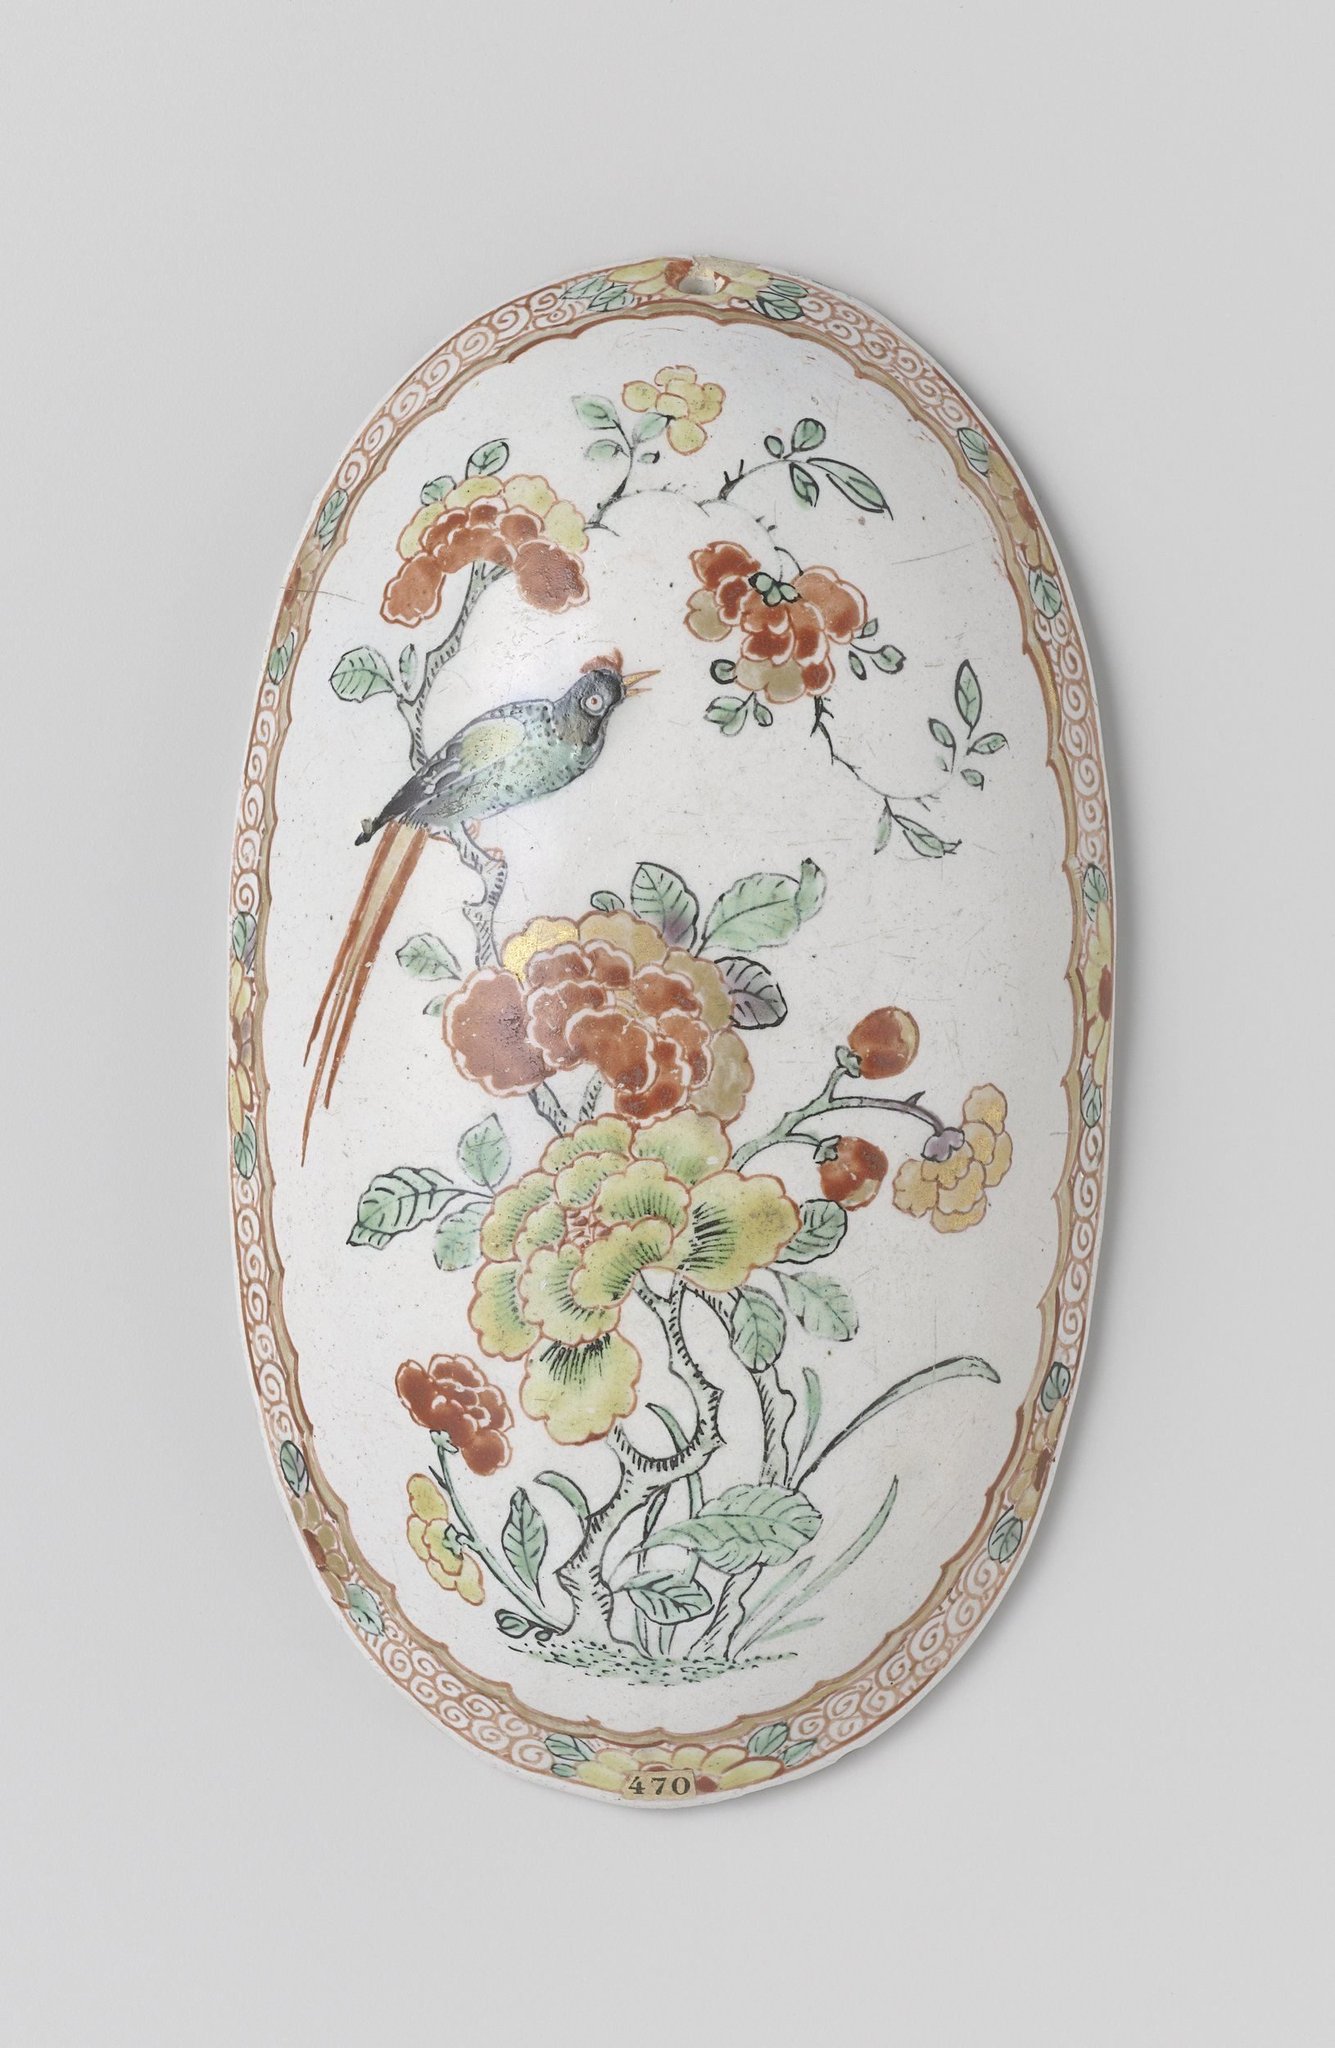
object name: borstelrug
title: Borstelrug van veelkleurig beschilderde faïence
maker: Anonymous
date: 1715-1740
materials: faience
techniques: kiln, painted, polychromy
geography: delft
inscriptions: collector's mark: ‘collection J.F. Loudon’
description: Brush back. Faience. Delft, c. 1715 - 1740. Given by the heirs of John F. Loudon, 1916.